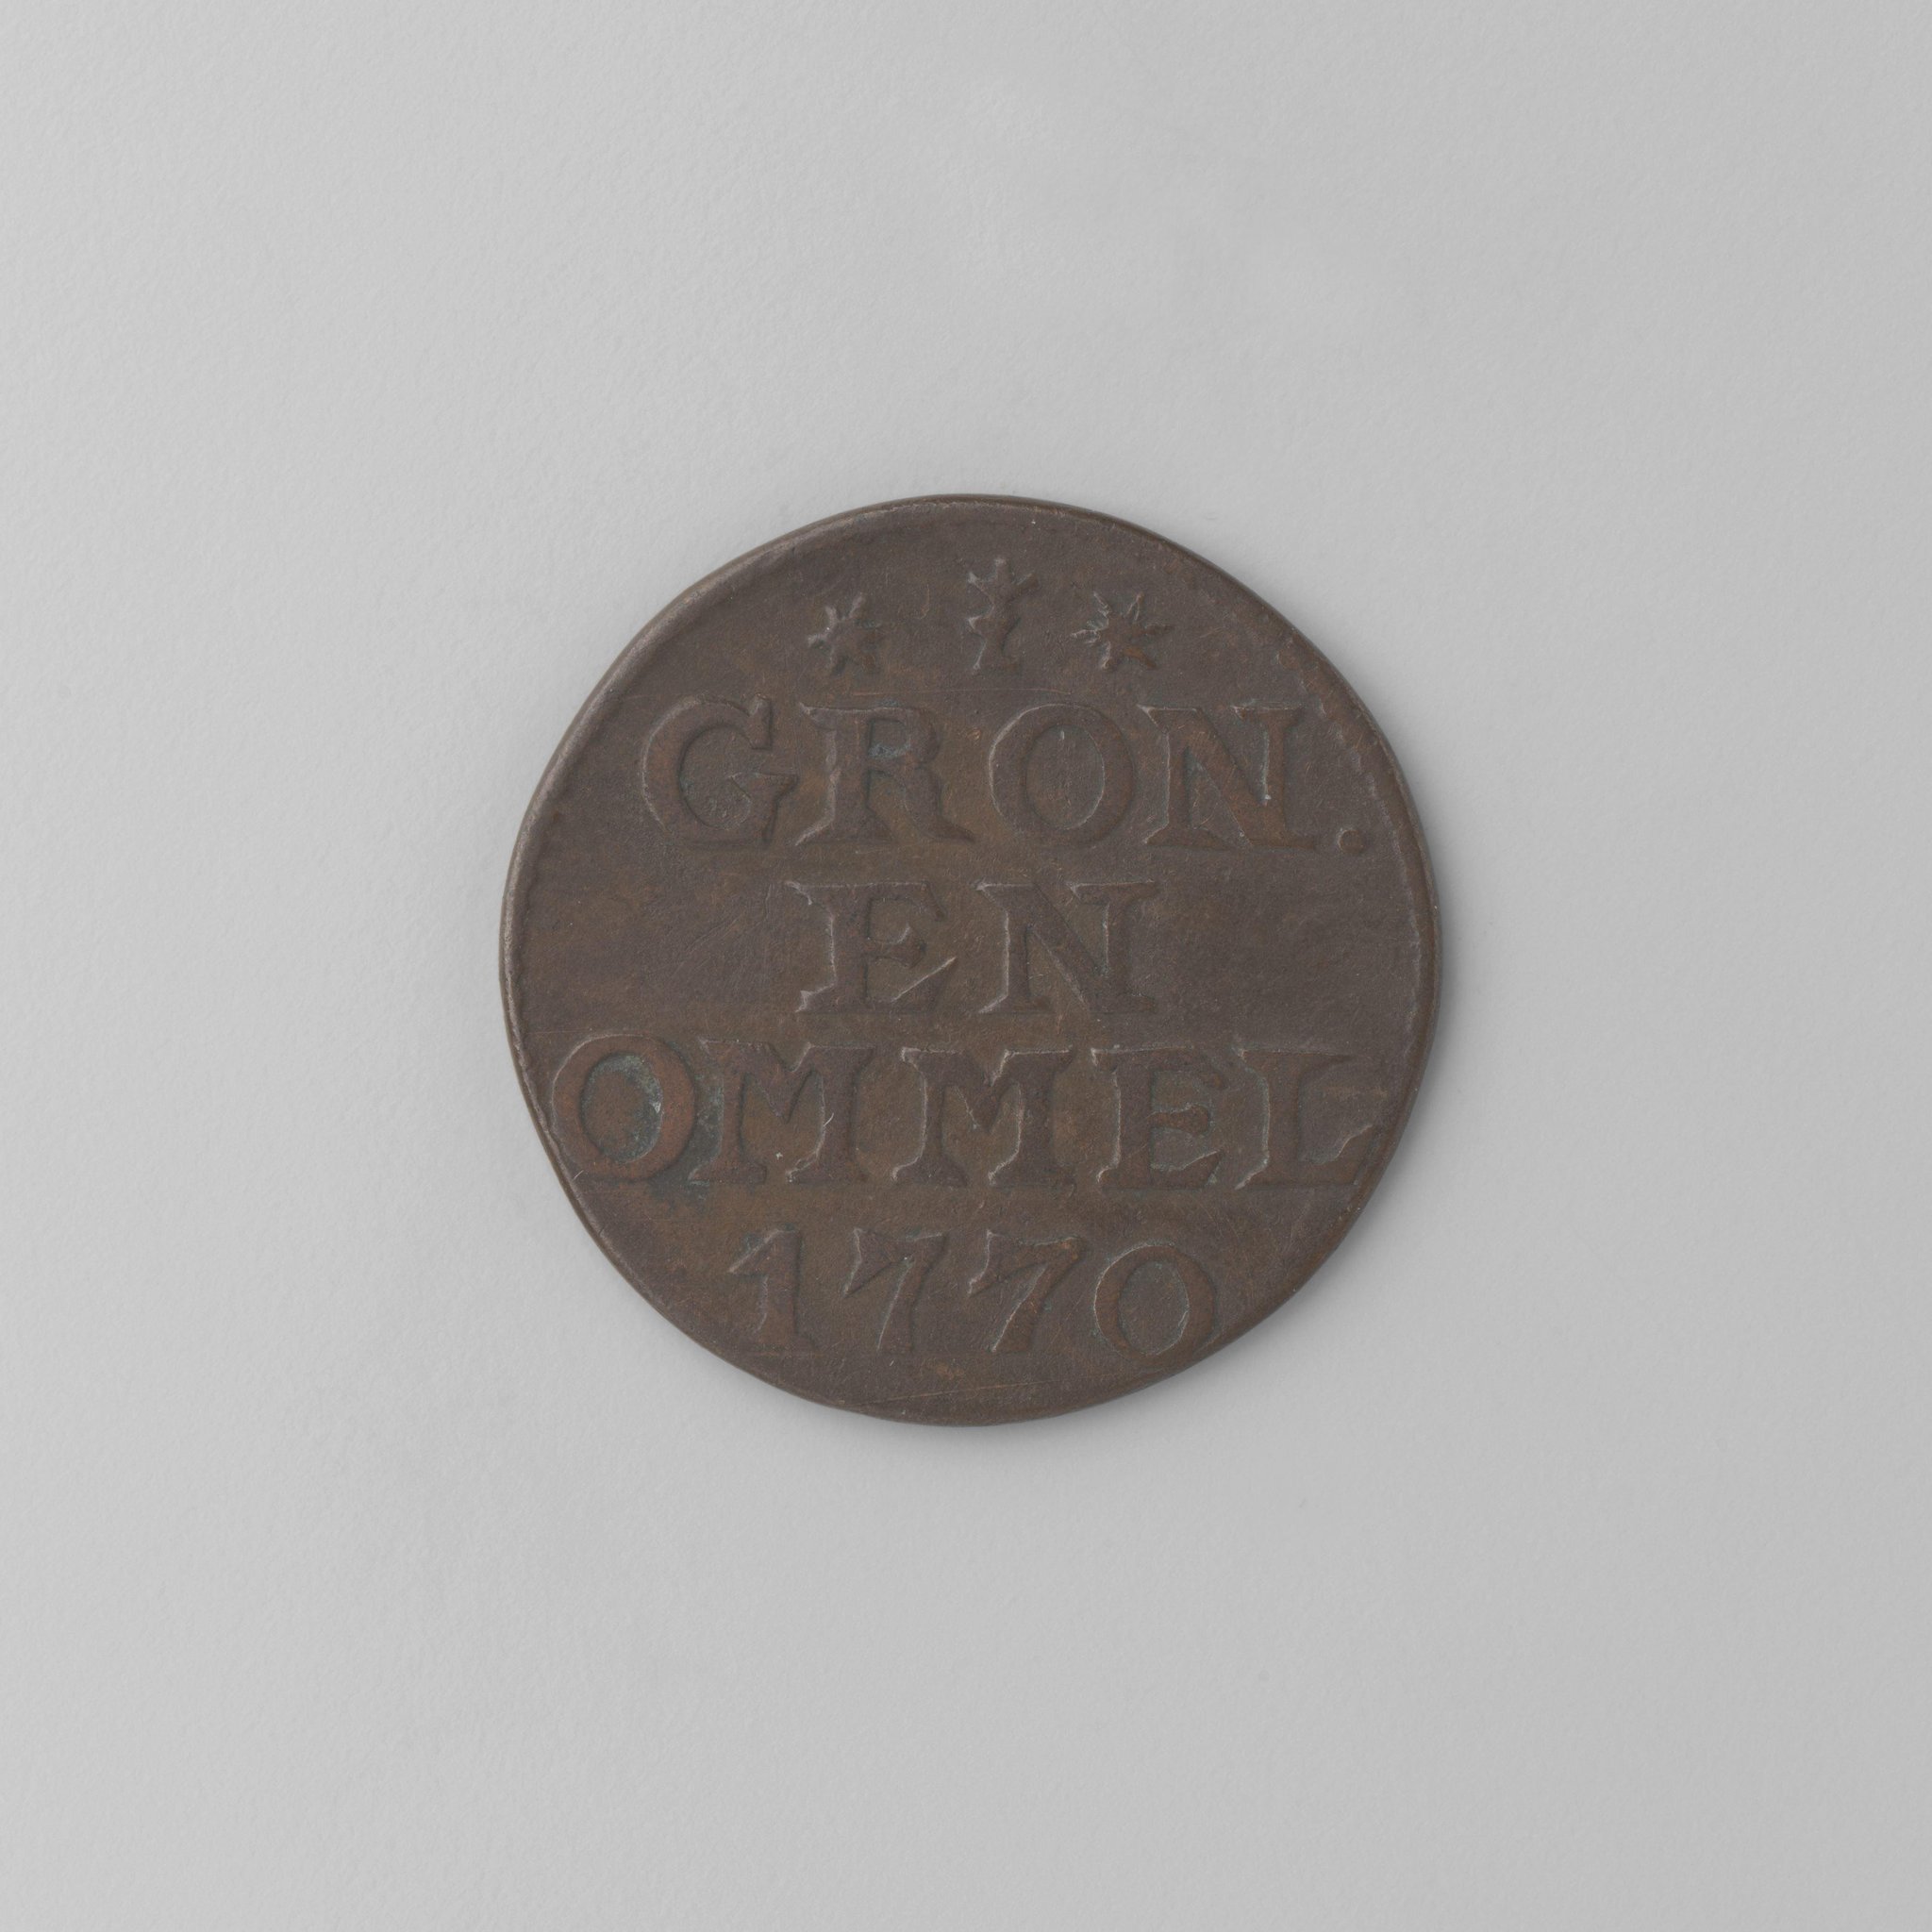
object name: coin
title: Groningen en de Ommelanden, duit, 1770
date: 1770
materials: copper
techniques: striking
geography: harderwijk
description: Koperen munt. Voorzijde: binnen versiering gekroond wapenschild. Keerzijde: drie-regelig opschrift, waarboven muntmeesterteken boompje van de muntmeester te Harderwijk en waaronder jaartal.